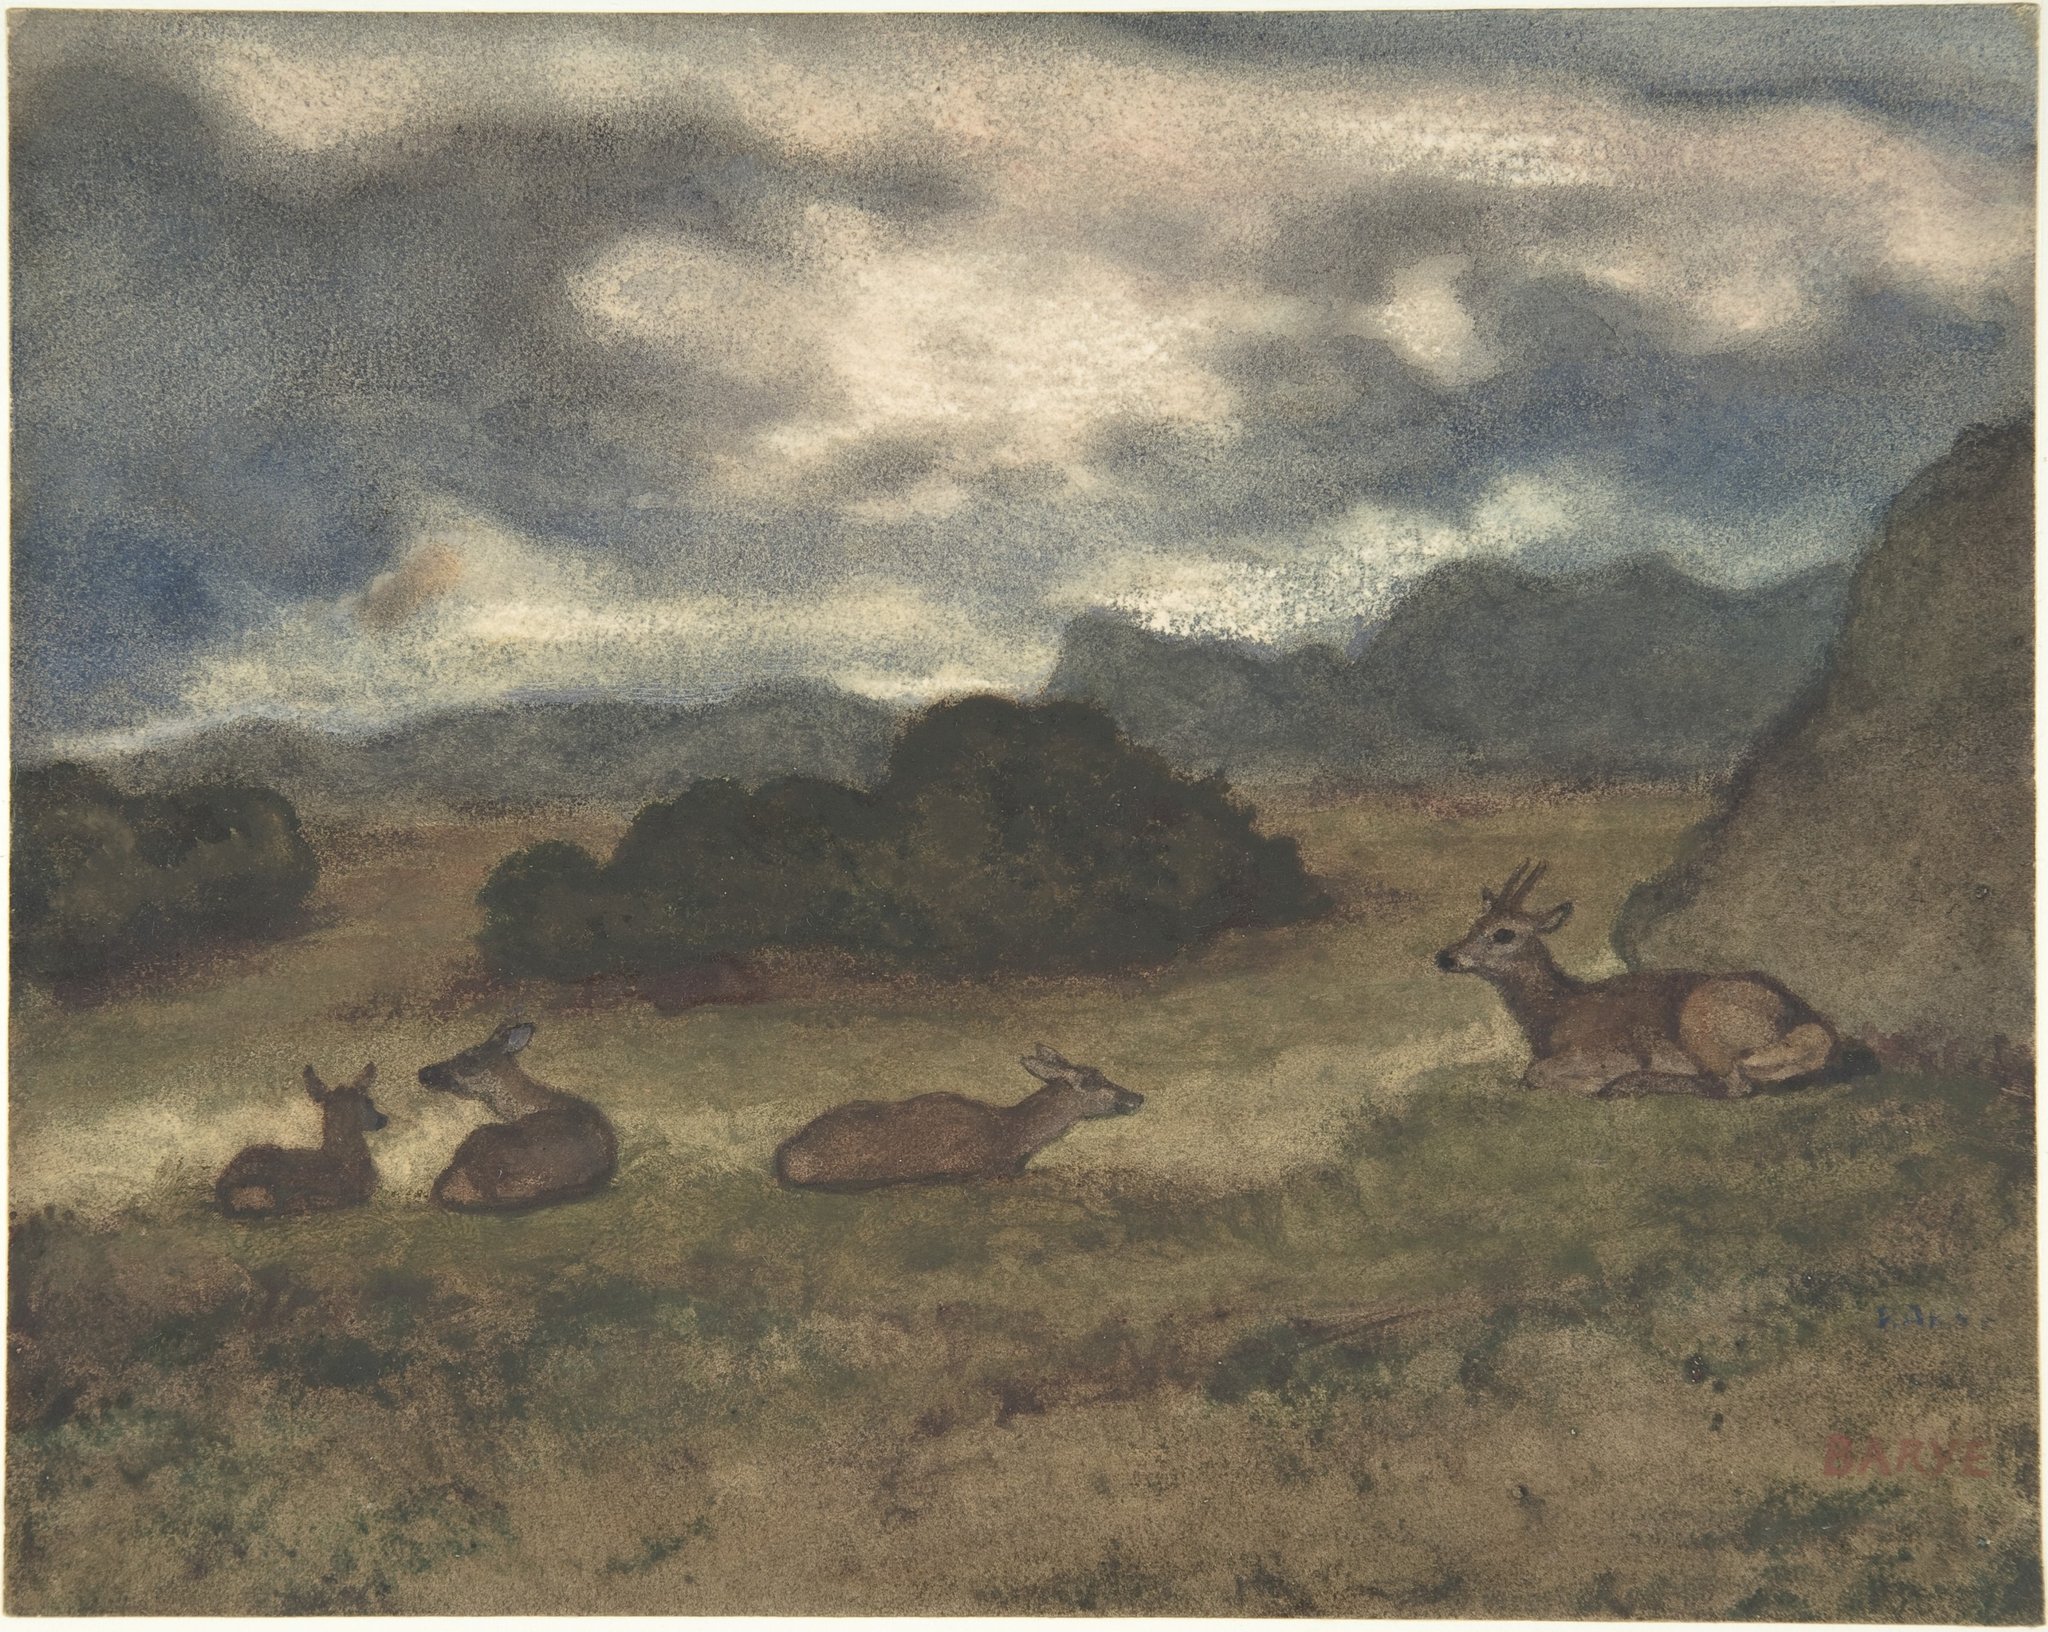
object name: drawing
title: Deer in Landscape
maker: antoine-louis barye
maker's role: artist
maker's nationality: french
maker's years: 1795-1875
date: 1810-1875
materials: watercolor, paper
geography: france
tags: deer,landscapes